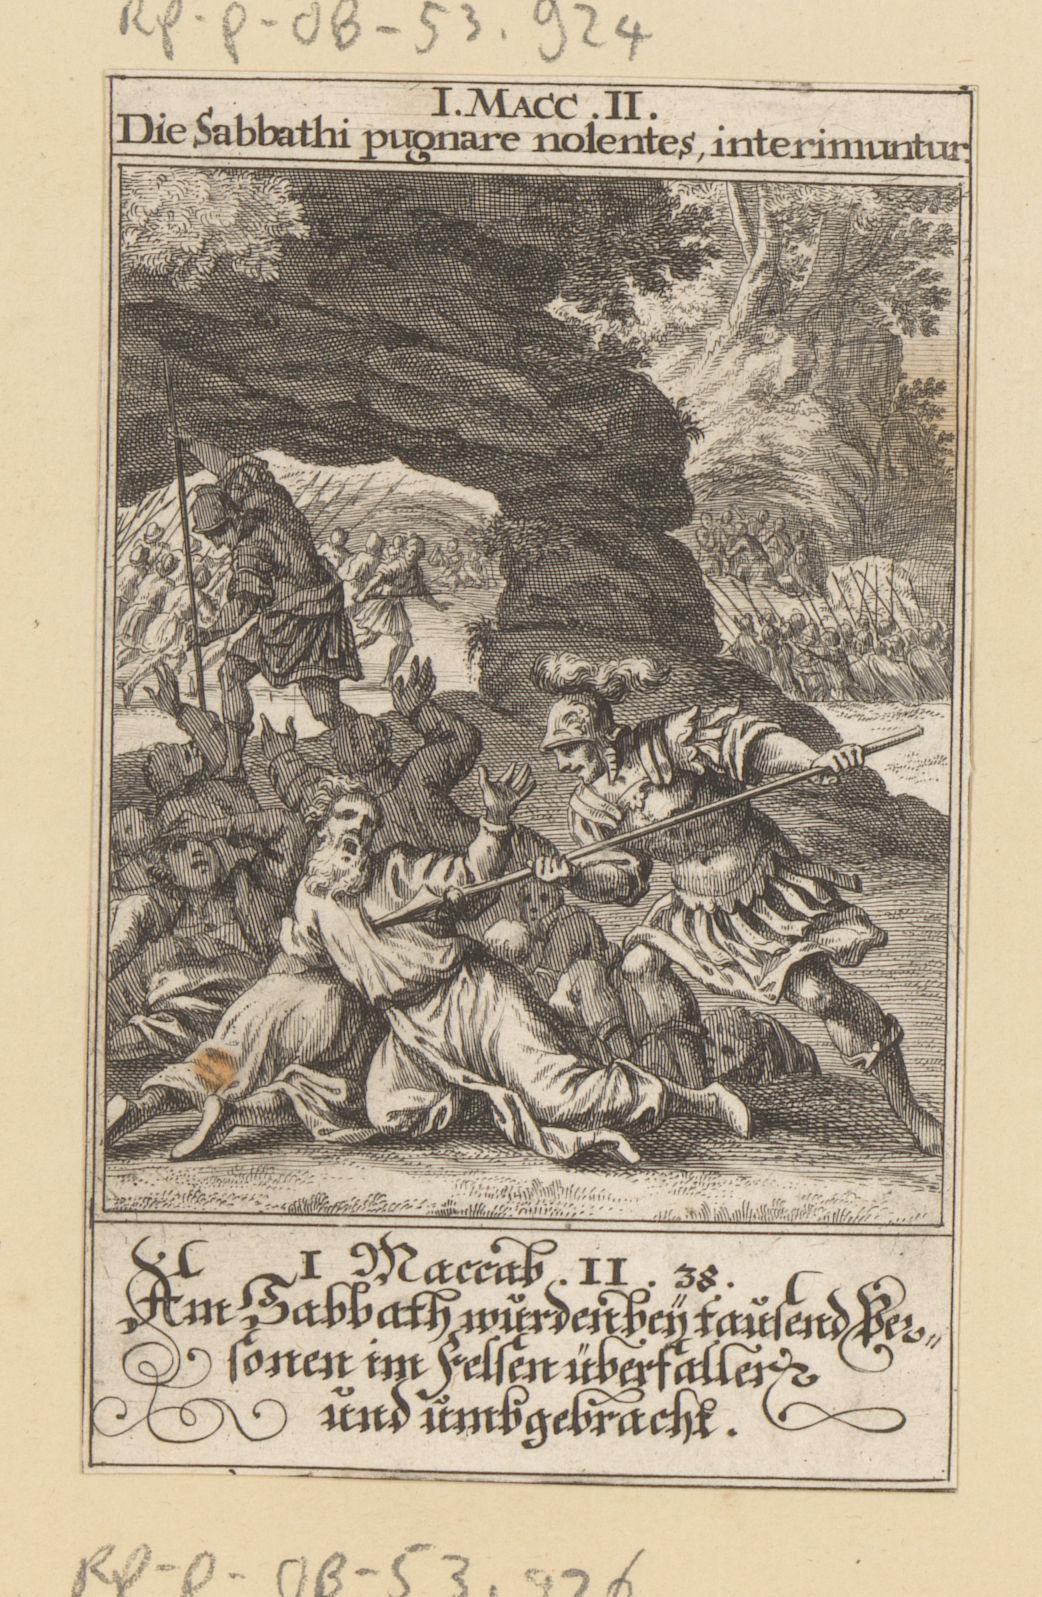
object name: print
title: Joden worden vermoord tijdens de Sabbath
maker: Anonymous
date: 1697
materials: paper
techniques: etching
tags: the jews without resistance slain on the sabbath (1 maccabees 2:31-38)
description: Prent ook gebruikt in: Biblia ectypa : Bildnussen auss Heiliger Schrifft. Regensburg: Chr. Wiegel, 1697.